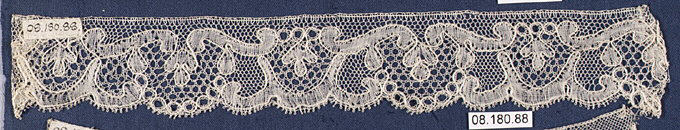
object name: fragment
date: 1801-1900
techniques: lace